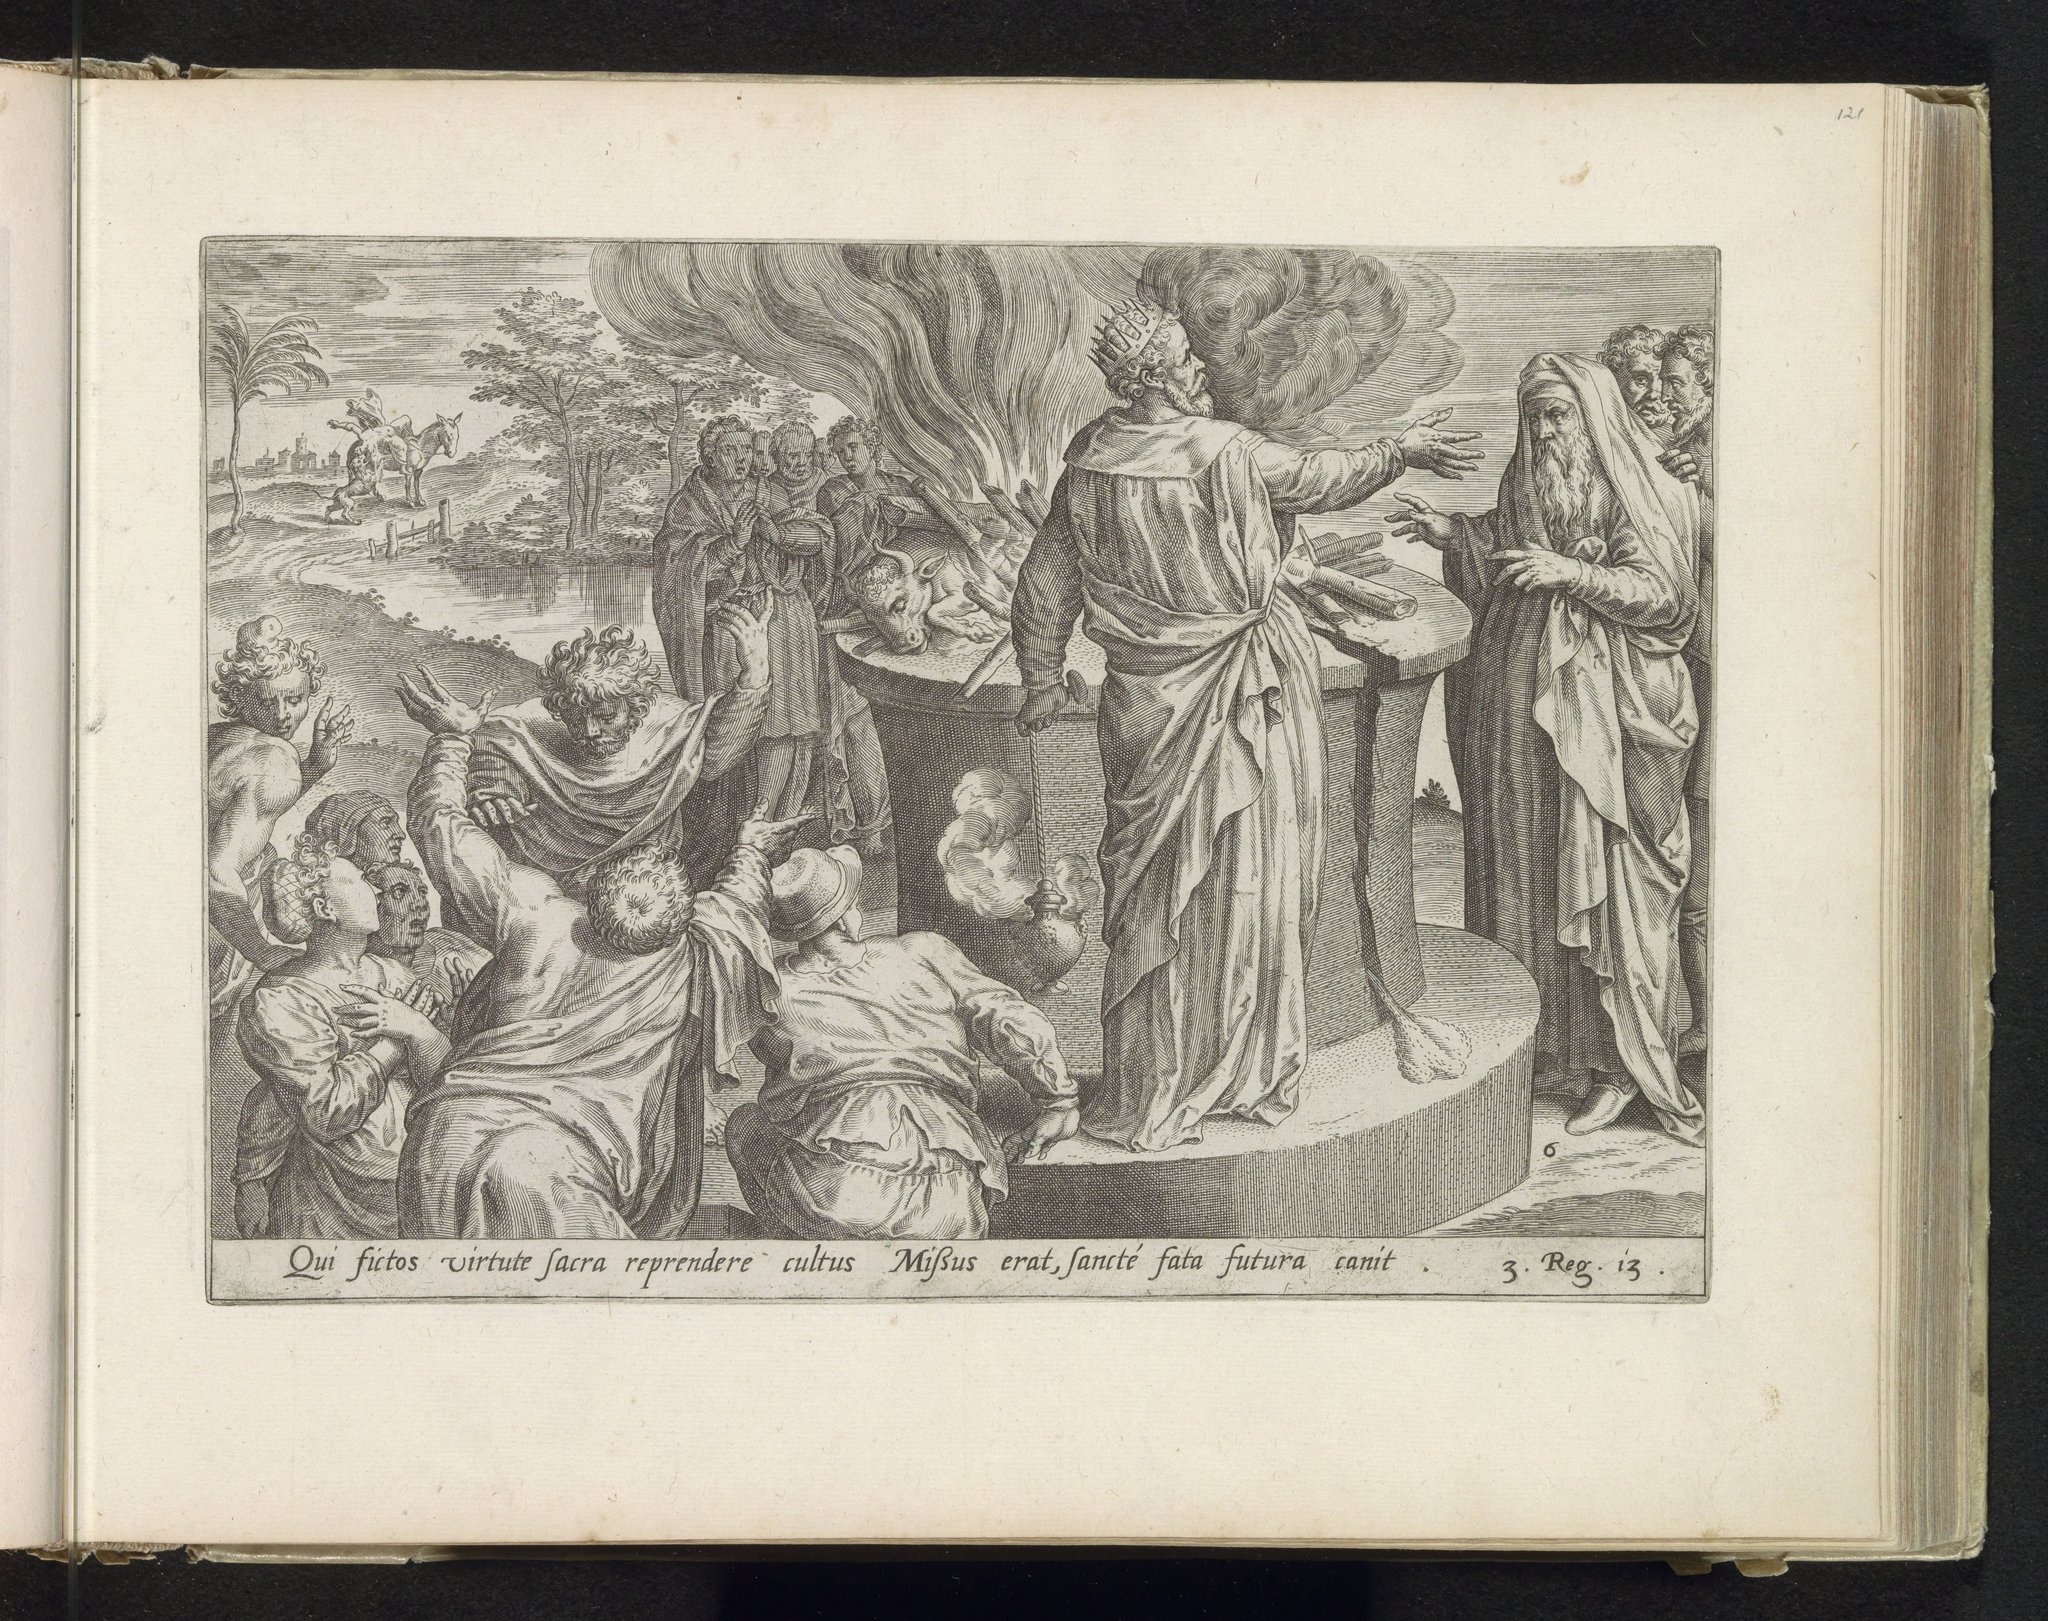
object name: album leaf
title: Thesaurus sacrarum historiaru[m] veteris testame[n]ti, elega[n]tissimis imaginibus expressu[m] excelle[n]tissimoru[m] in hac arte viroru[m] opera: nu[n]c primu[m] in luce[m] editus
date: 1585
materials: paper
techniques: engraving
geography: antwerp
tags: 'a man of god' from judah comes to bethel and prophesies to jeroboam the destruction of the altar, as king jeroboam points to the prophet and orders his seizure, his hand withers and the altar falls apart, the prophet of judah rides off with his donkey and on his way is killed by a lion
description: Koning Jerobeam brengt een offer aan een afgod als een godsman uit Juda verschijnt. De godsman profeteert en kondigt het wonder aan dat het altaar zal splijten en de as op de grond zal vallen. De uitgestrekte arm van Jerobeam verstijft als hij de opdracht geeft de godsman gevangen te nemen. Links op de achtergrond is het einde van de godsman verbeeld. De godsman wordt gedood door een leeuw en van zijn ezel getrokken. Onder de voorstelling een verwijzing in het Latijn naar de Bijbeltekst in 1 Kon. 13. Deze prent maakt deel uit van een album.